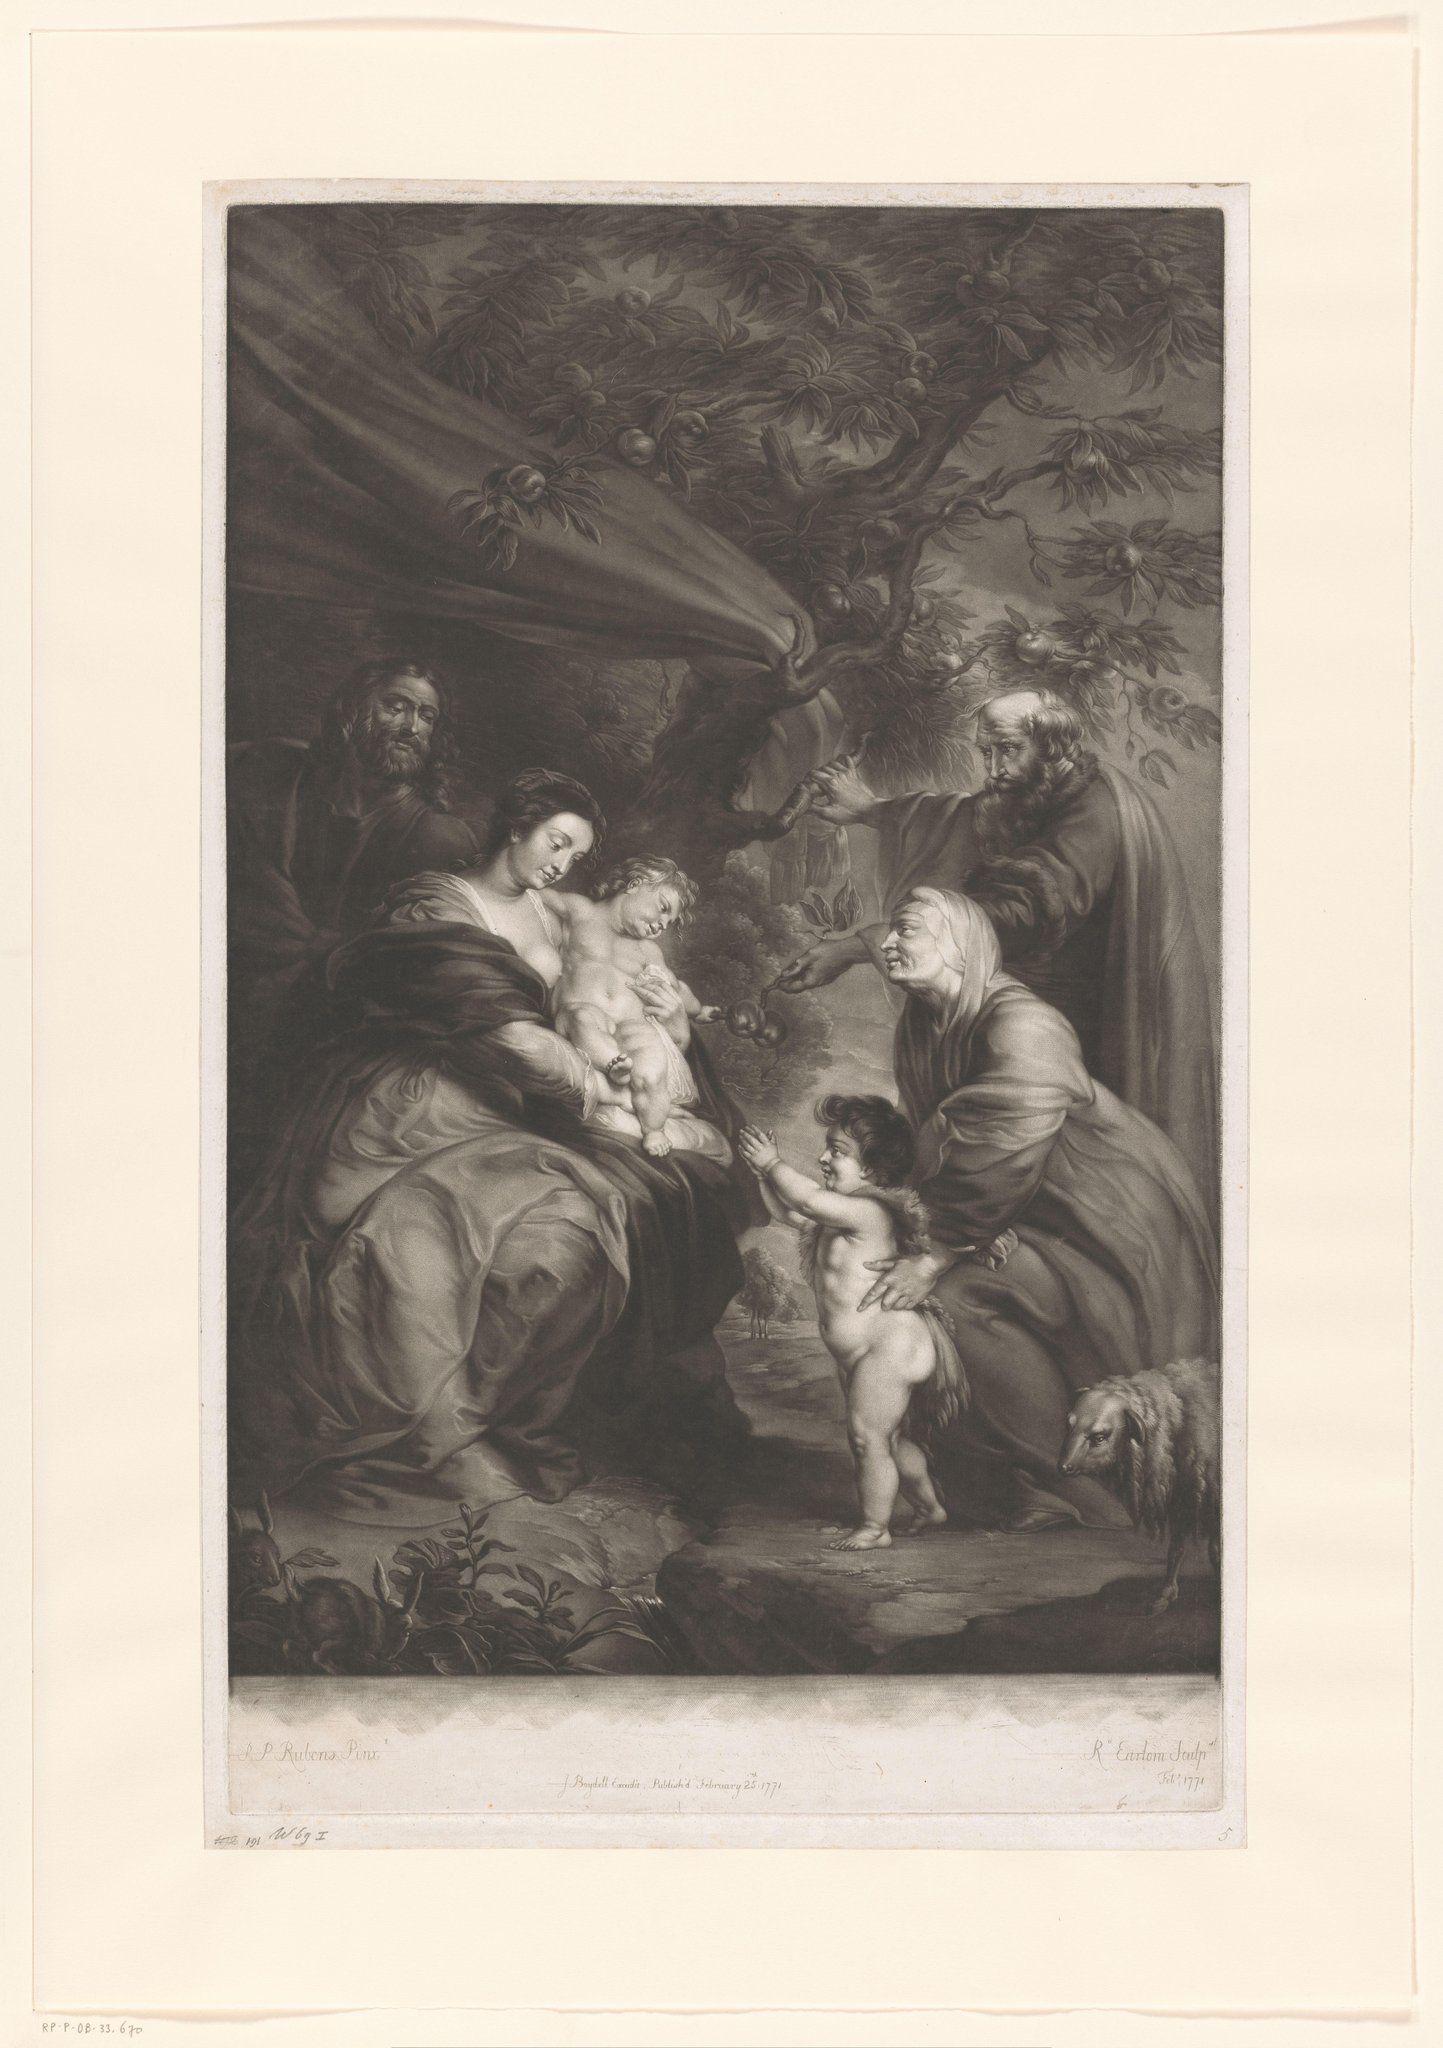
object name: print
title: Heilige Familie met Elisabet, Zacharias en Johannes de Doper als kind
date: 1702-1771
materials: paper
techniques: mezzotint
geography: london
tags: holy family with john the baptist; elisabeth and zacharias present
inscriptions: collector's mark: Lugt 240